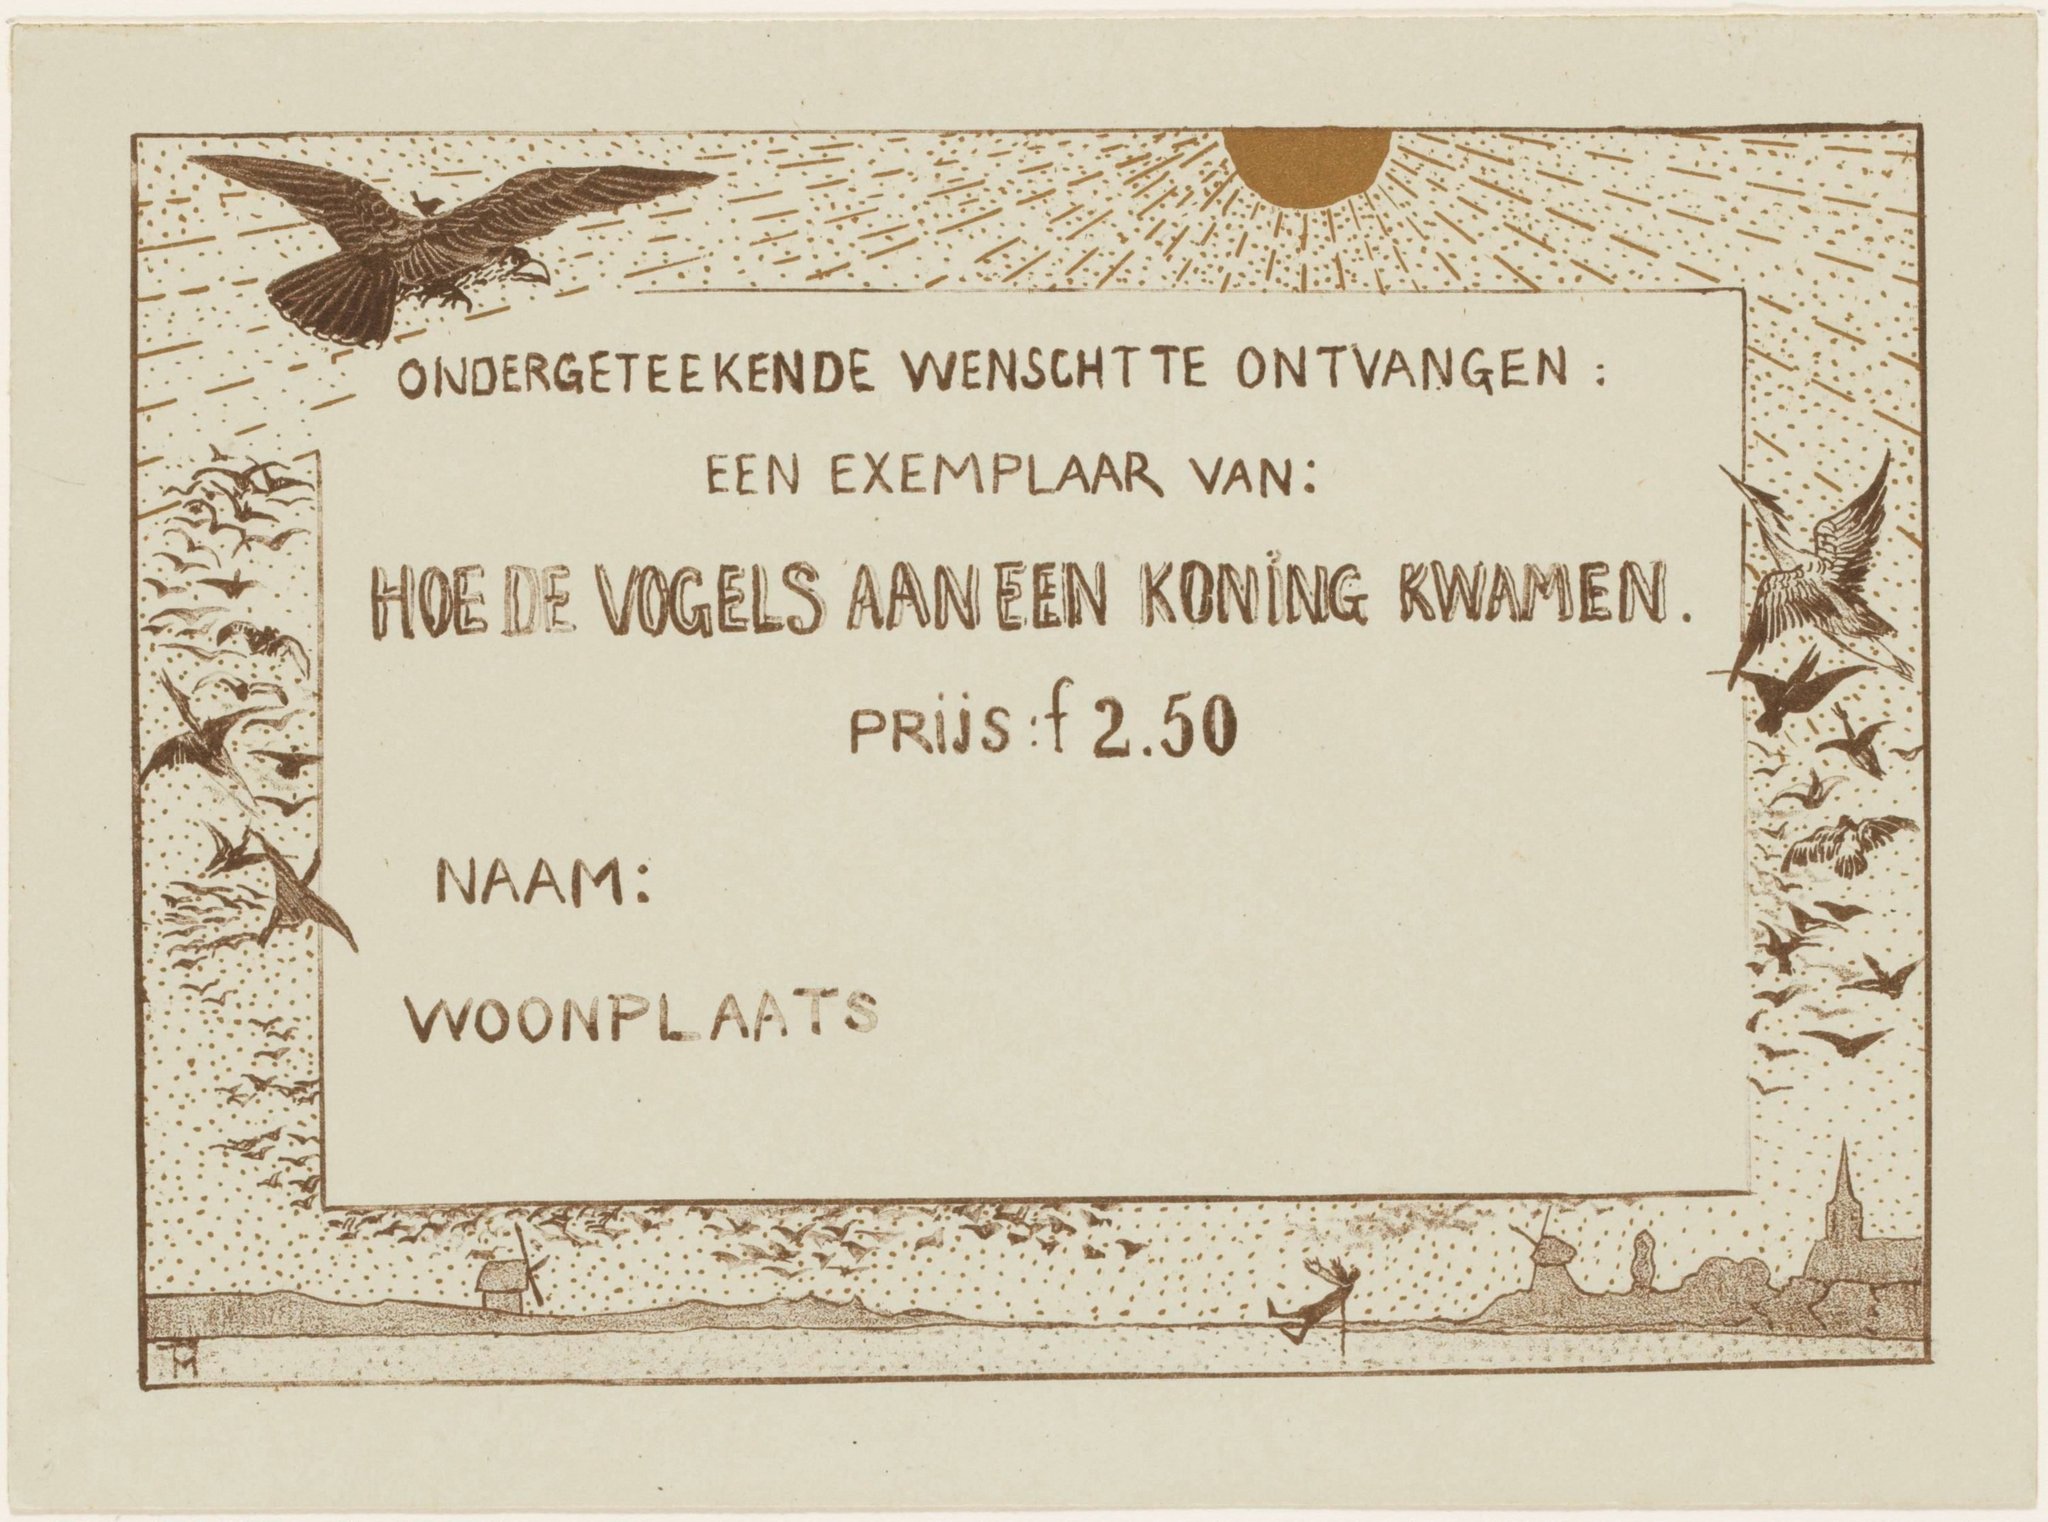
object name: print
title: Bestelkaart voor 'Hoe de vogels aan een koning kwamen'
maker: theo van hoytema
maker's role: draughtsman, painter, print maker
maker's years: 1863-1917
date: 1892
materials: paper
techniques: lithograph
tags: shore-birds and wading-birds: heron, song-birds: crow, birds, windmill in landscape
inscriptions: collector's mark: Lugt 2233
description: In de rand een groep vliegende vogels boven een landschap met molens.